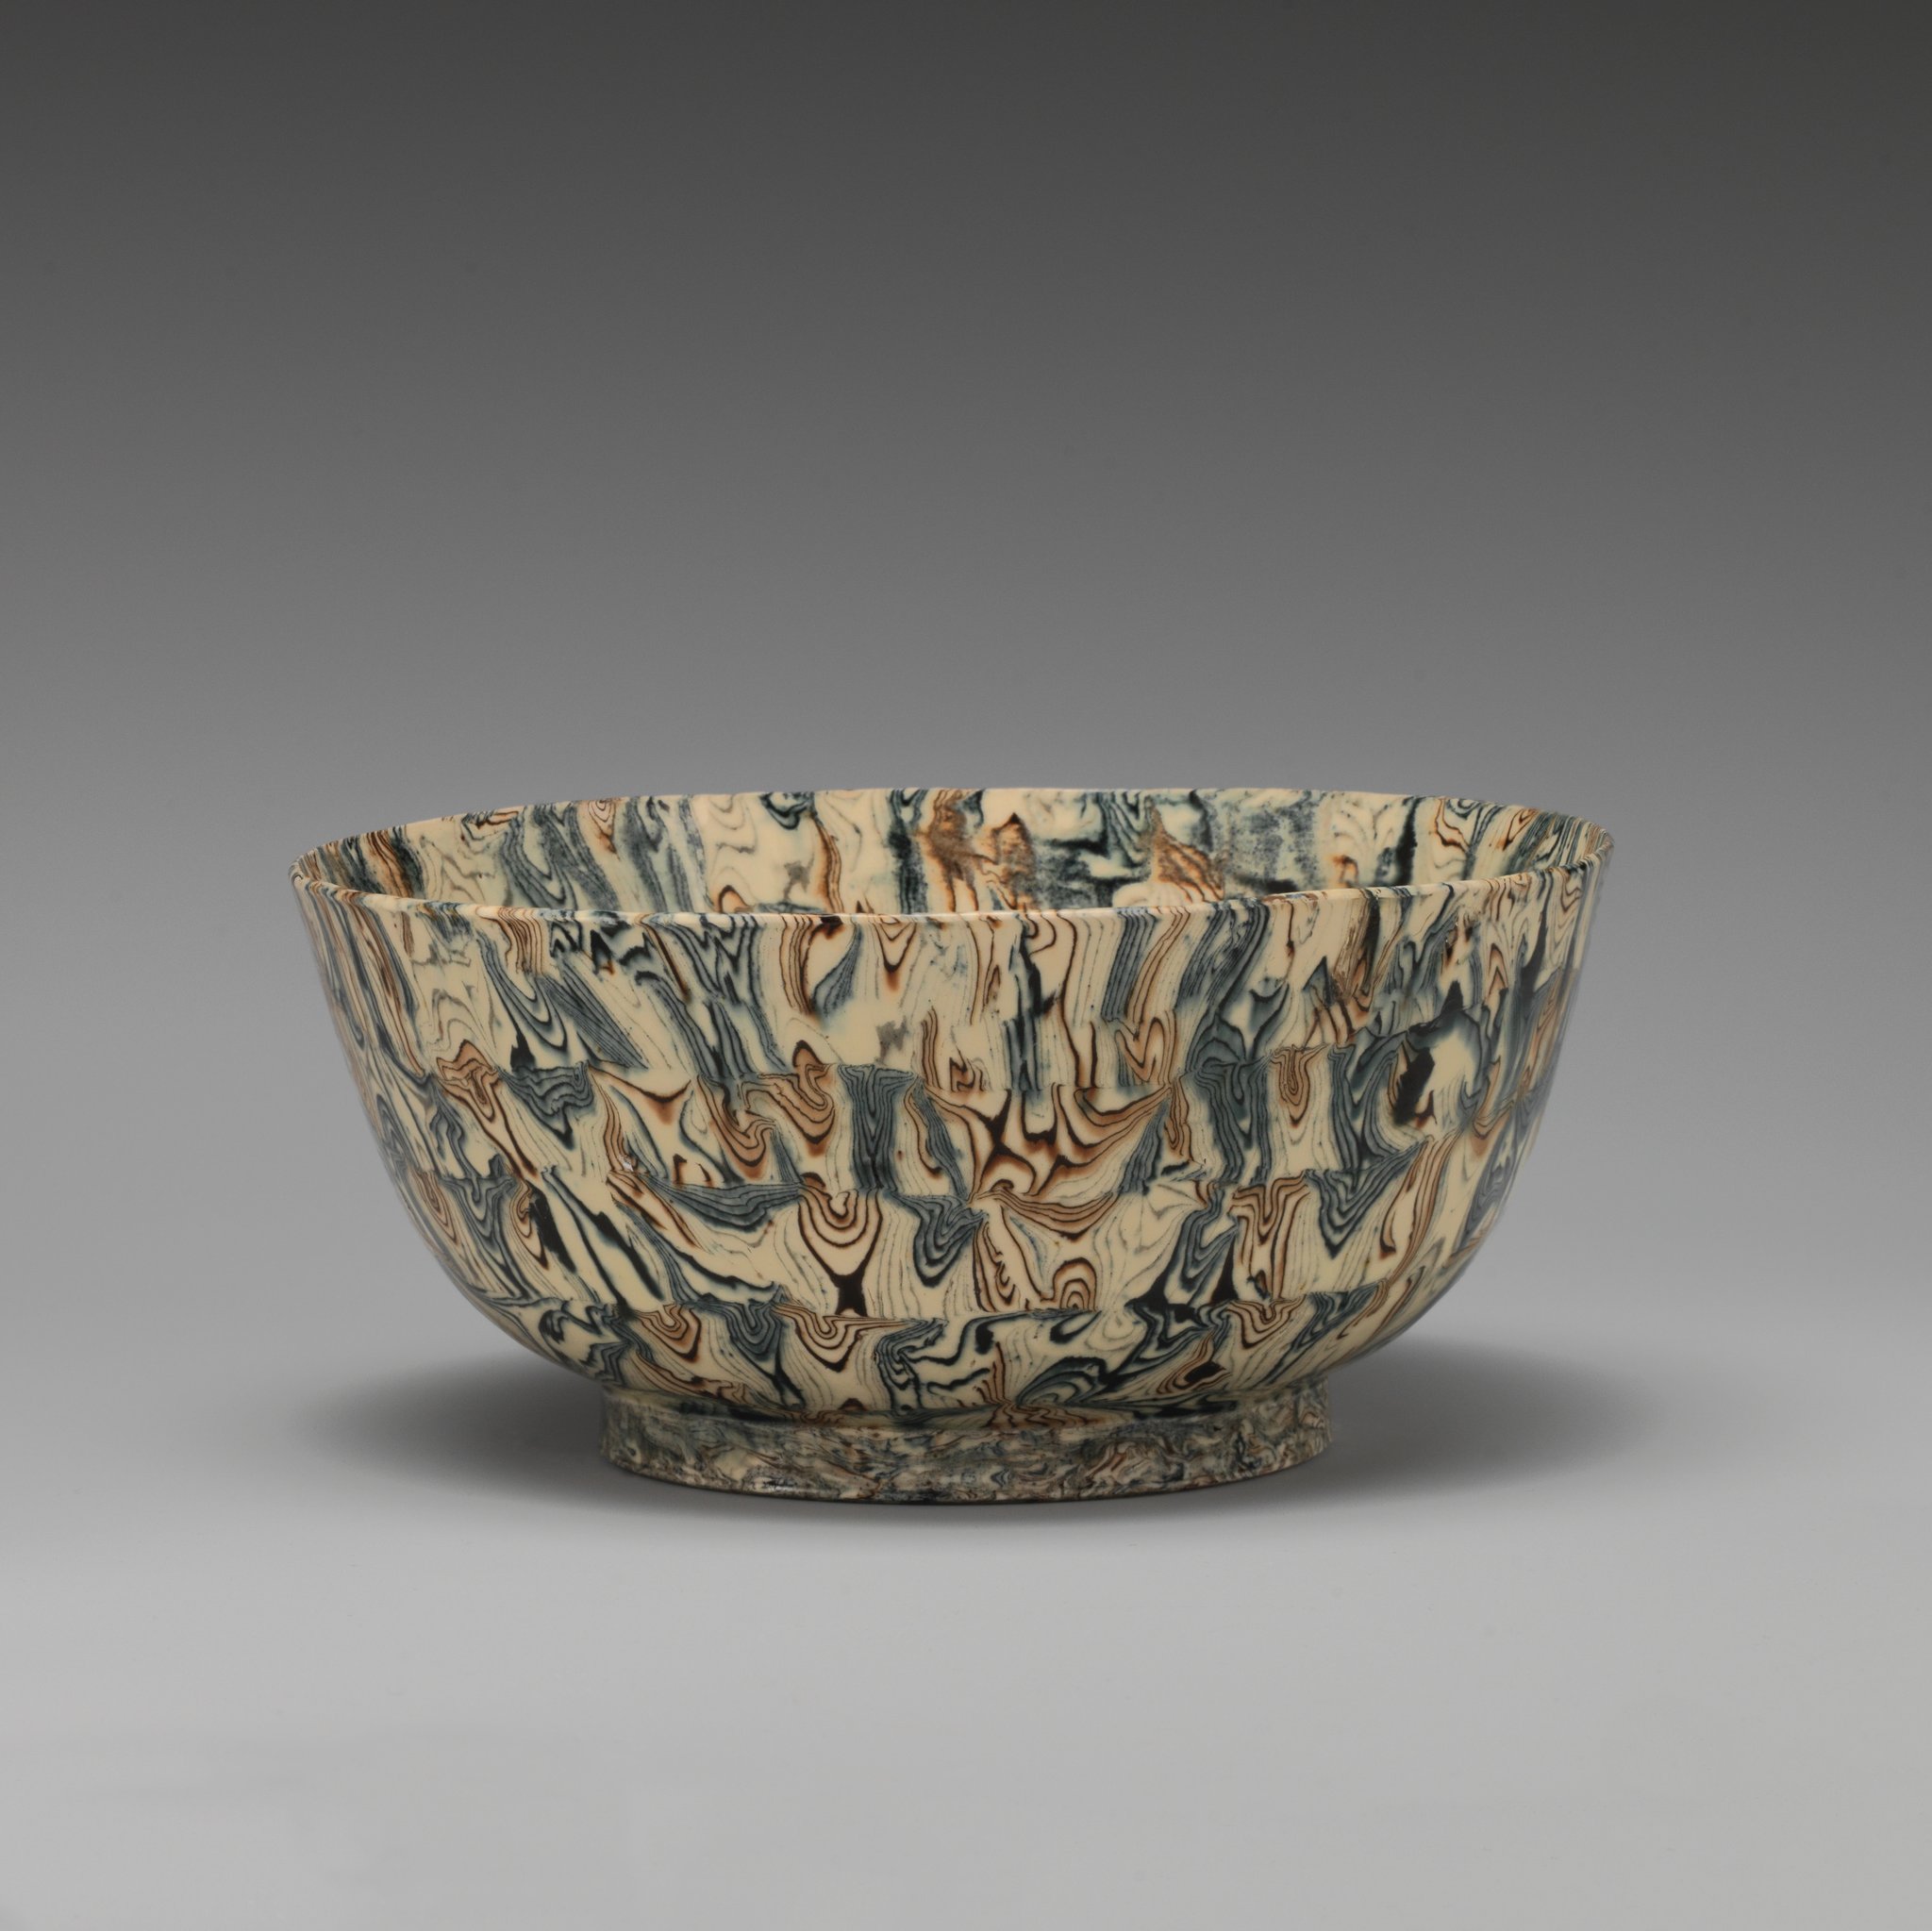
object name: bowl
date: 1750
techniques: glazing